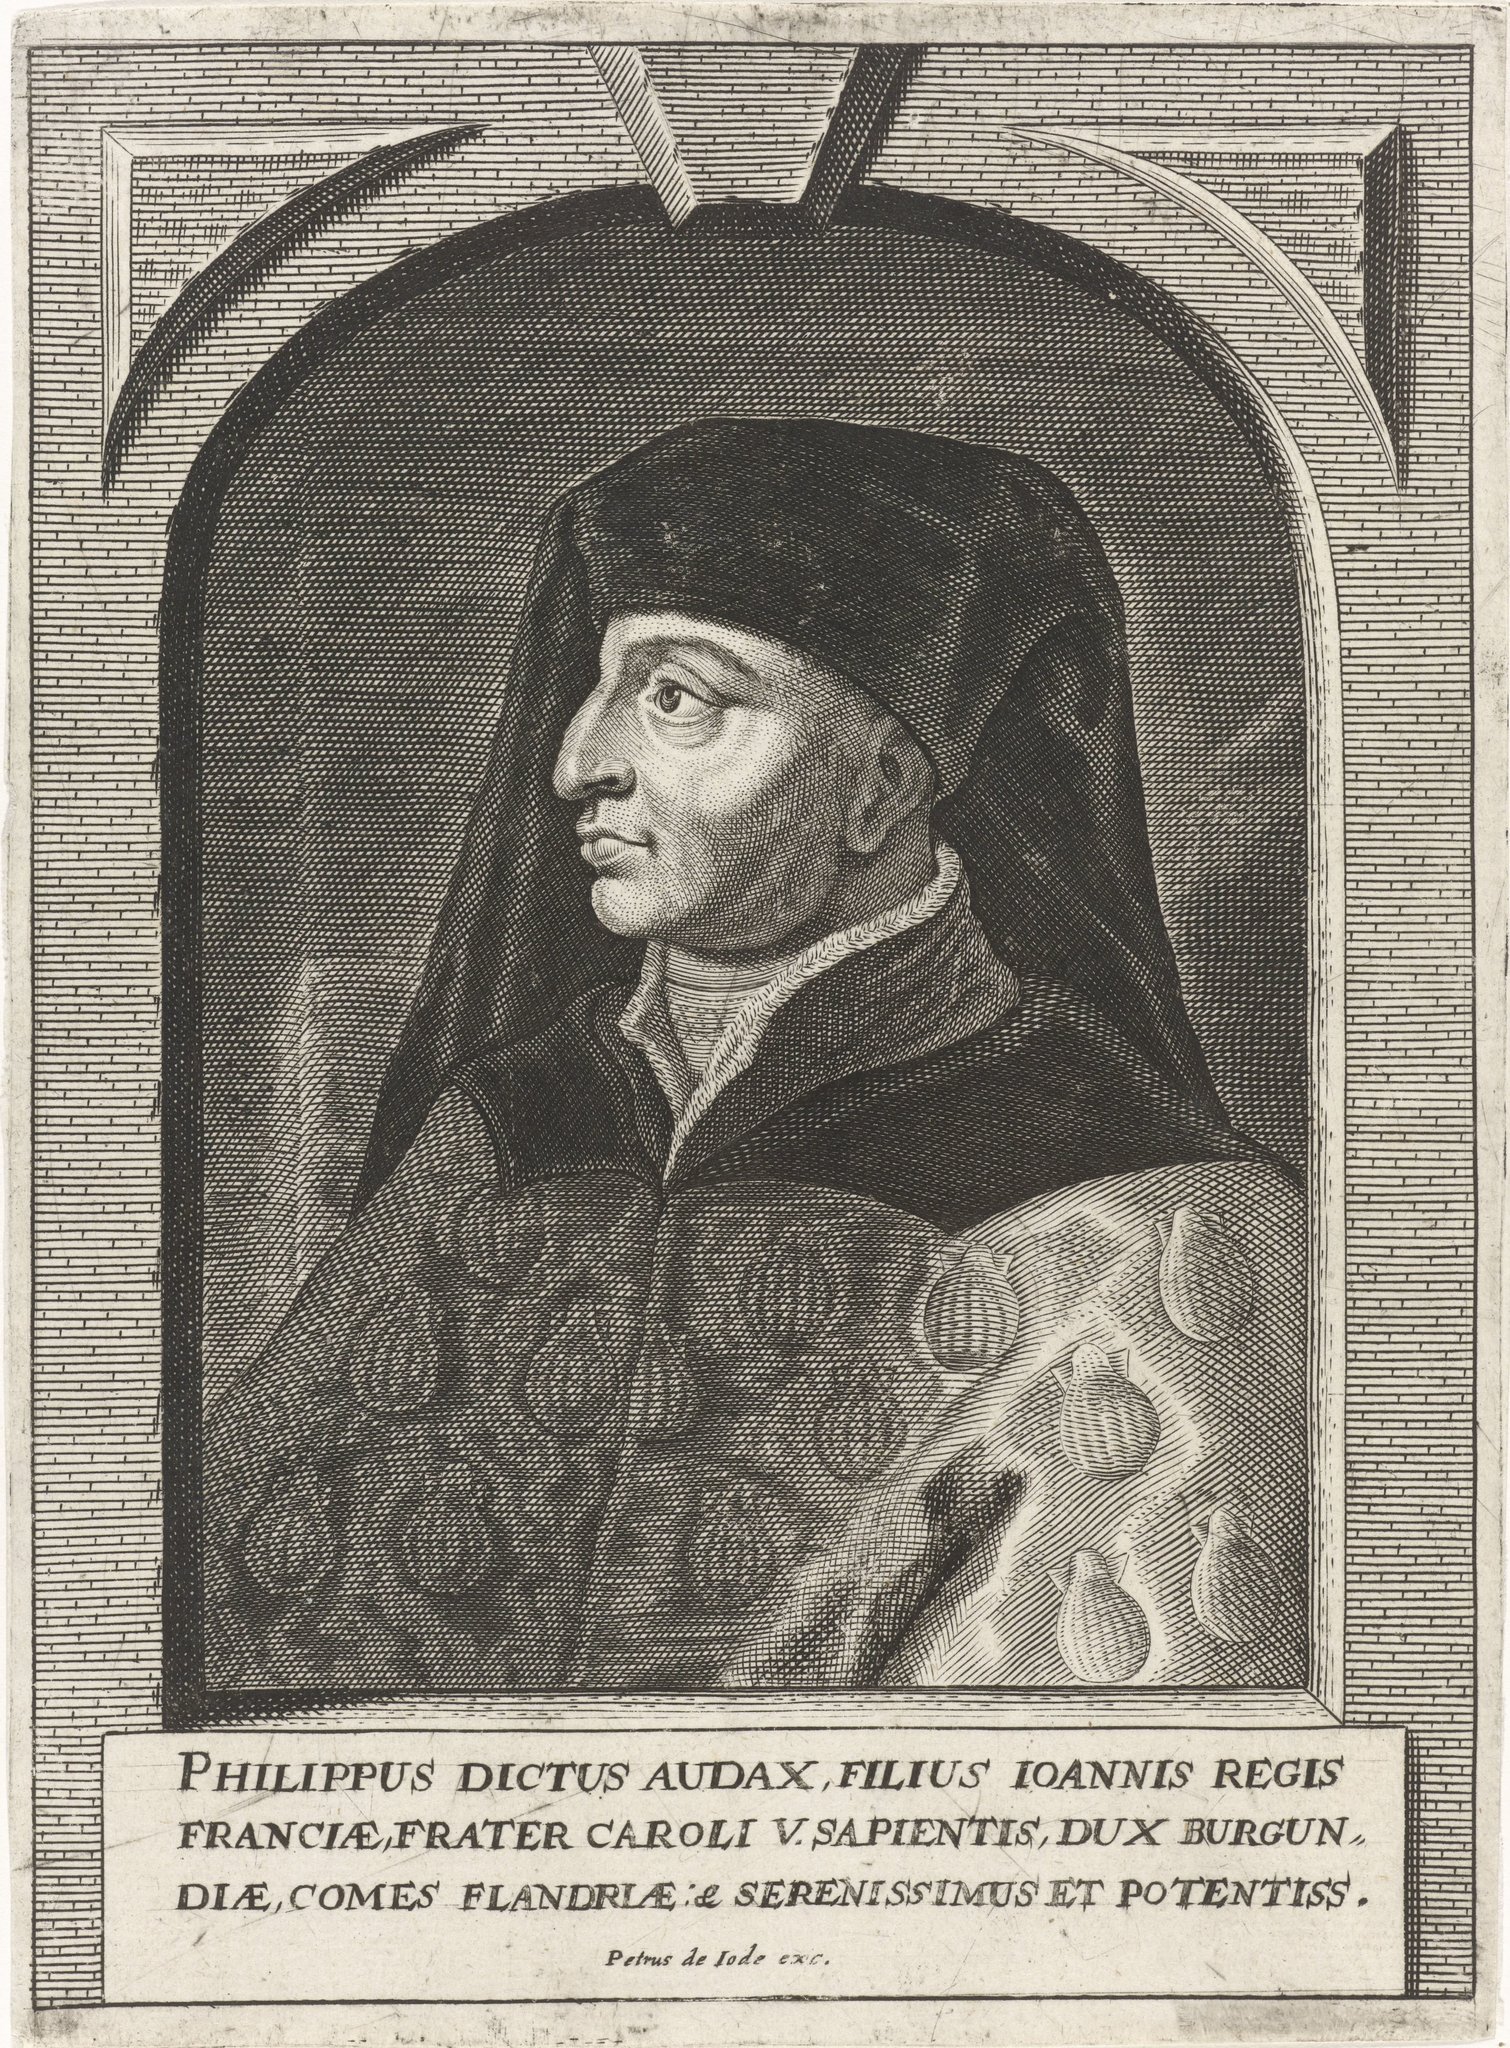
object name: print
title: Portret van Filips II de Stoute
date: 1628-1670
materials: paper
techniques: engraving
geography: antwerp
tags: halle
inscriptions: collector's mark: Lugt 2228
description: Busteportret van Filips II de Stoute, hertog van Bourgondië, met hertogskap. Het portret is gevat in een boogvormige omlijsting. In het kader een drieregelig onderschrift in het Latijn.